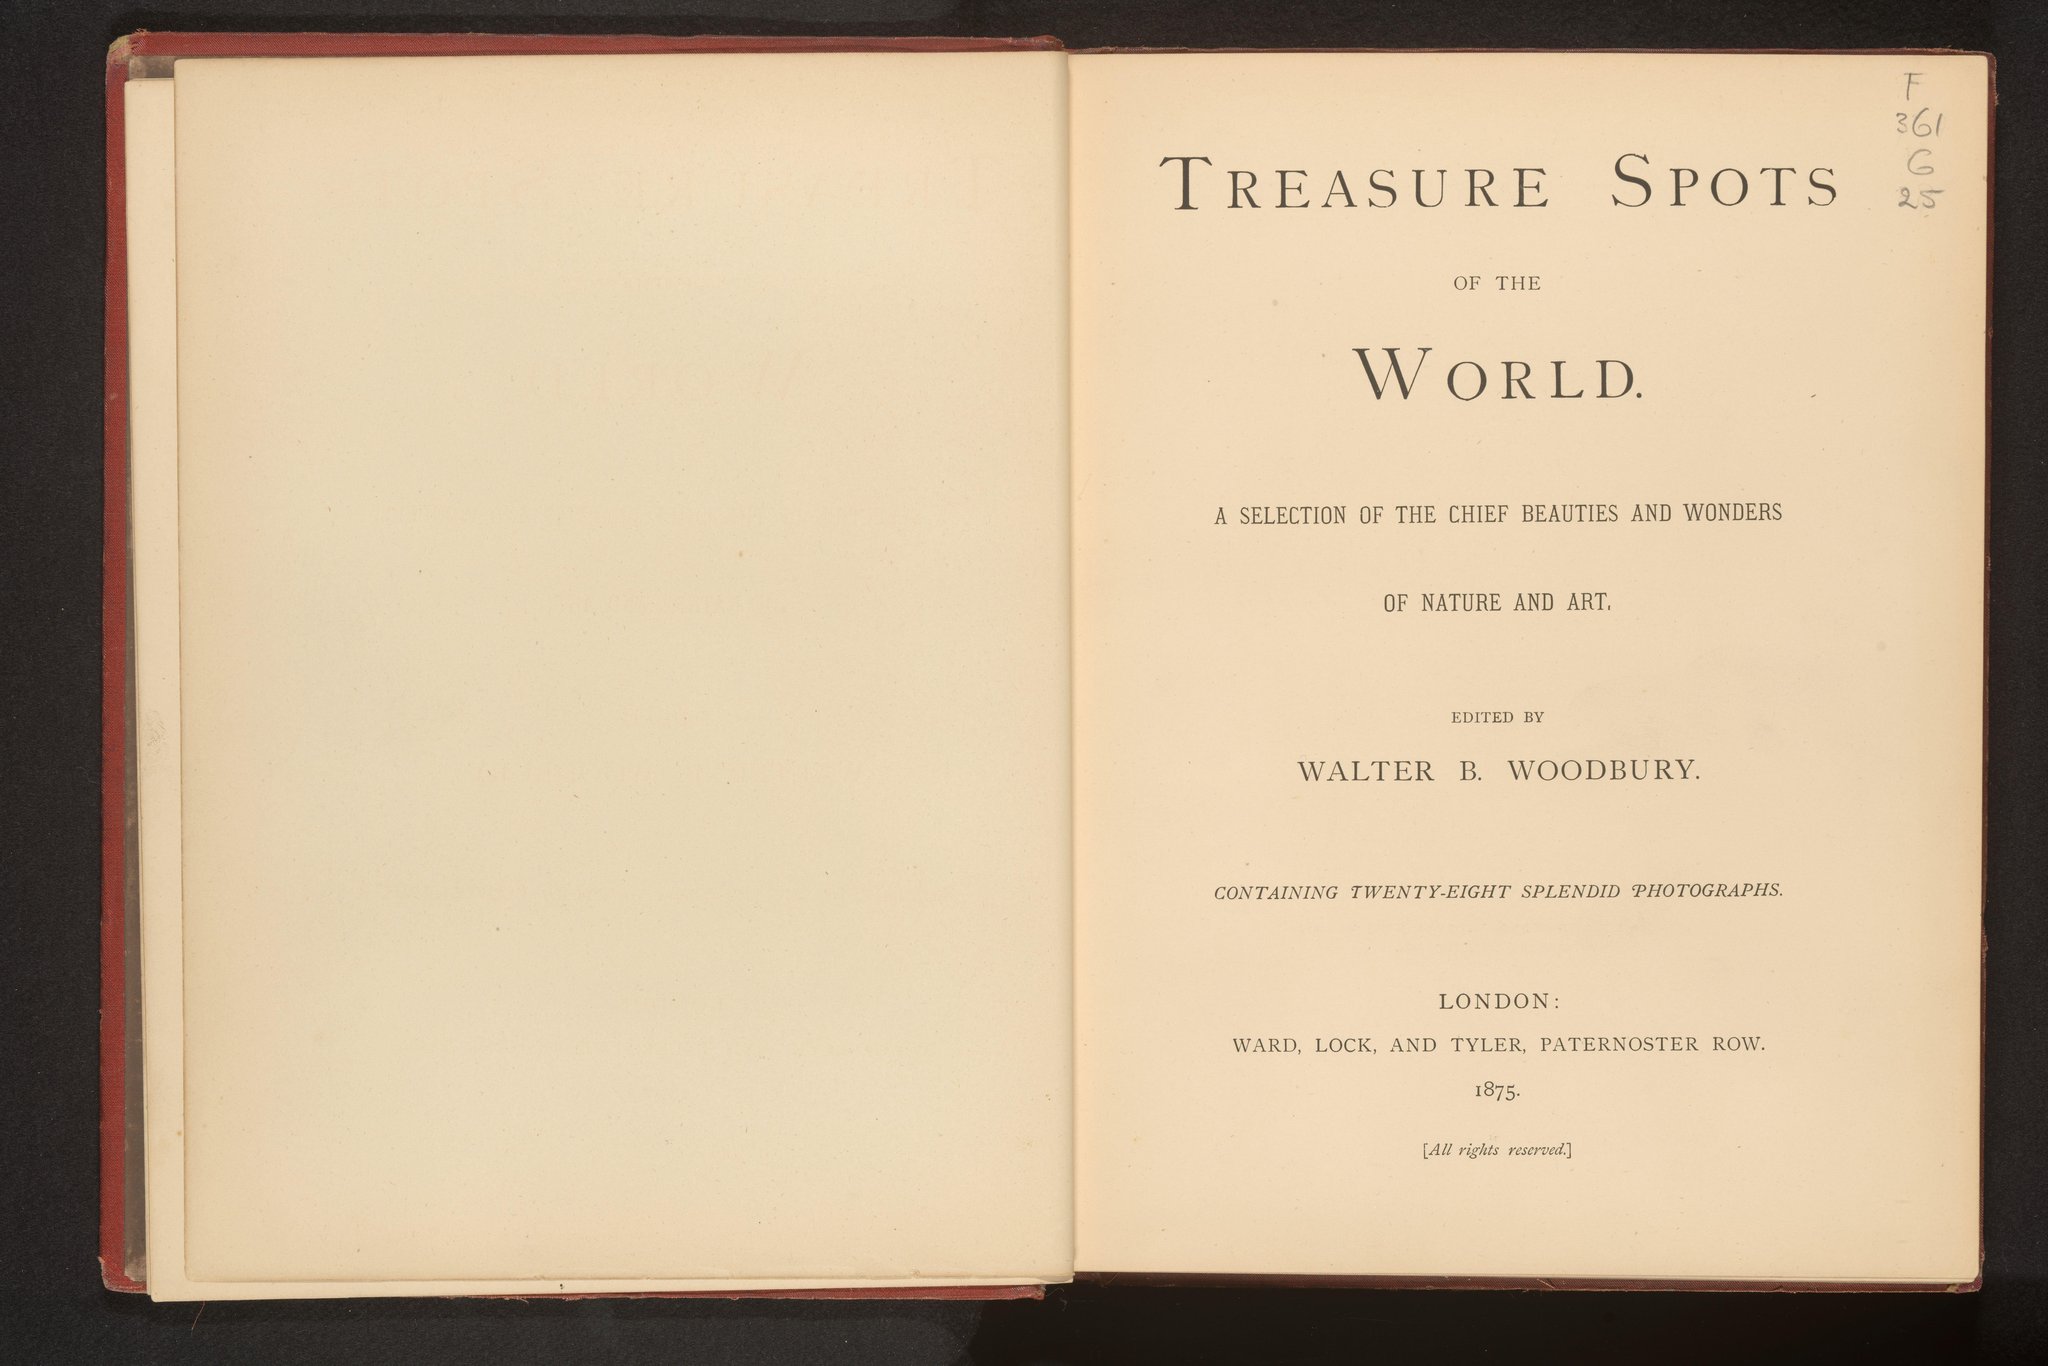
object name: book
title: Treasure spots of the world : a selection of the chief beauties and wonders of nature and art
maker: walter bentley woodbury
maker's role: fotograaf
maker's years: 1834-1885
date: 1875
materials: cardboard, leather, linen, paper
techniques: printing, woodburytype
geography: london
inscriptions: date: ‘MAY 1994’, number: ‘21’, annotation: ‘[...] 1875’